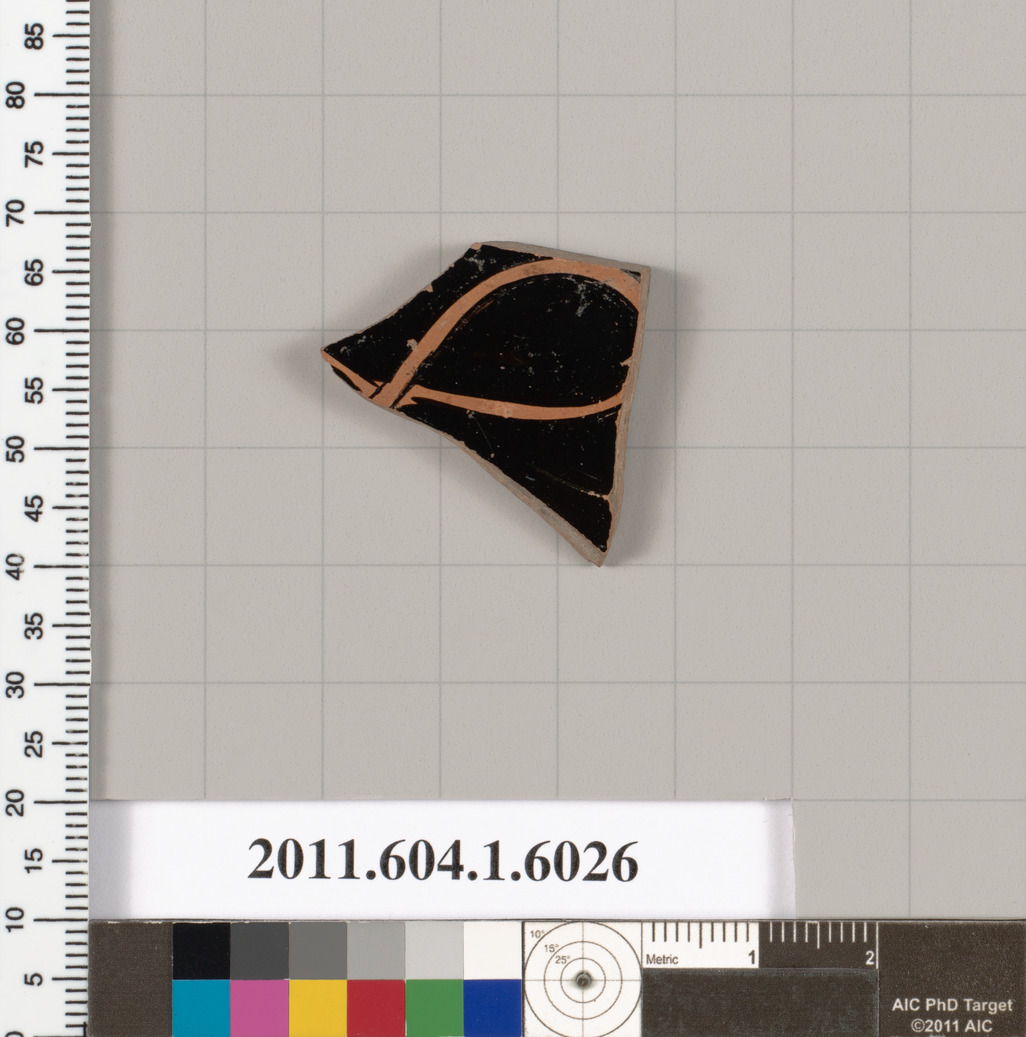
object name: kylix fragment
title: Terracotta fragment of a kylix (drinking cup)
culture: greek, attic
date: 510-500 BCE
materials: terracotta